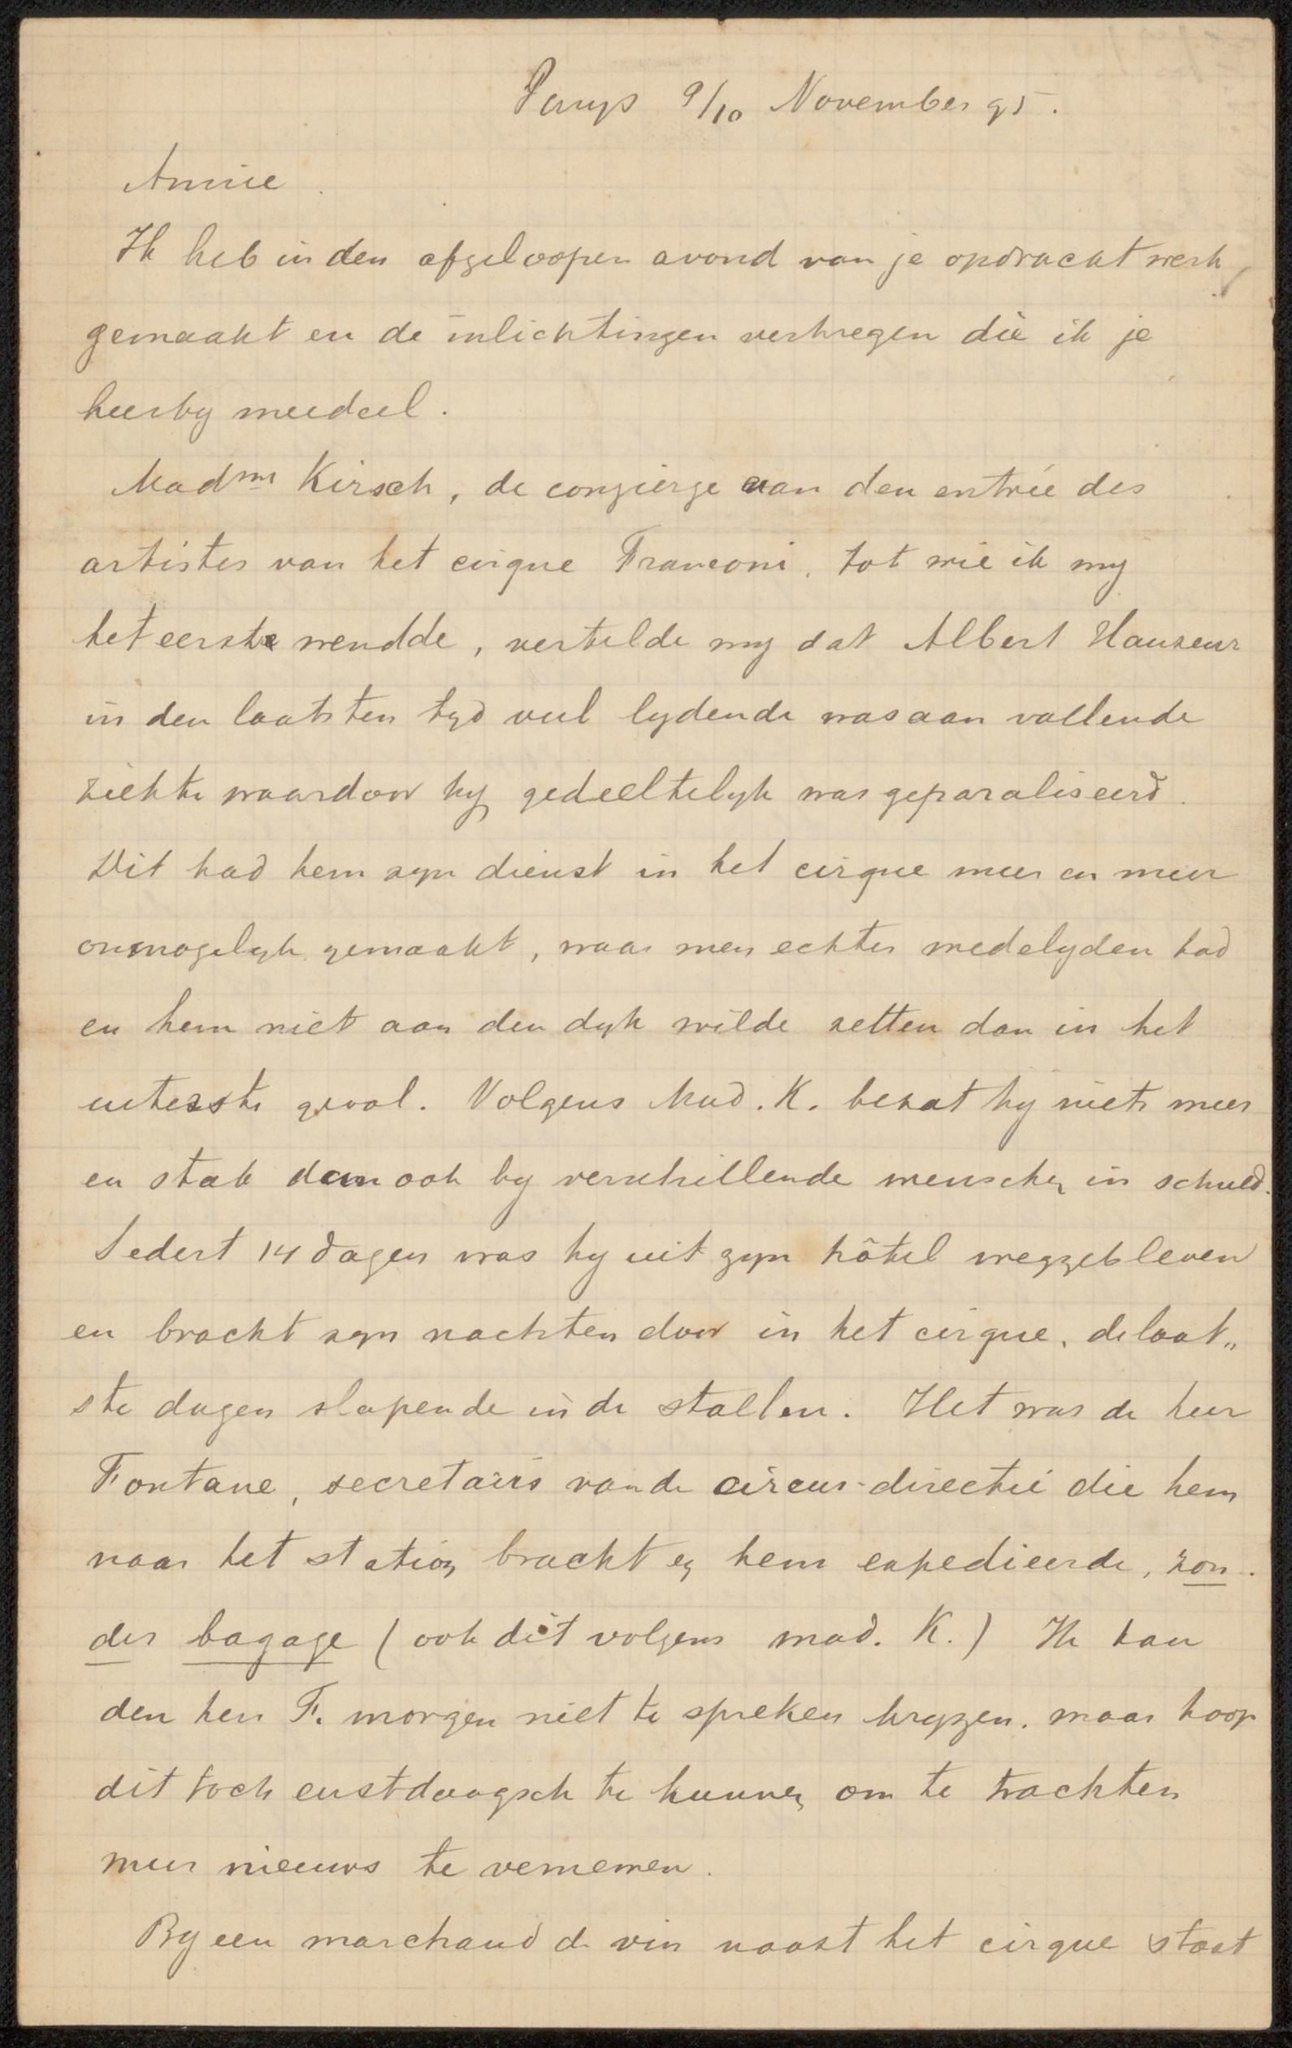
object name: letter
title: Brief aan Philip Zilcken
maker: charles snabilié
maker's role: journalist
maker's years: 1856-1927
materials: ink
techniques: pen, writing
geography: paris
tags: the hague, painter, draughtsman, philip zilcken, diseases, money, paris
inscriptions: watermark